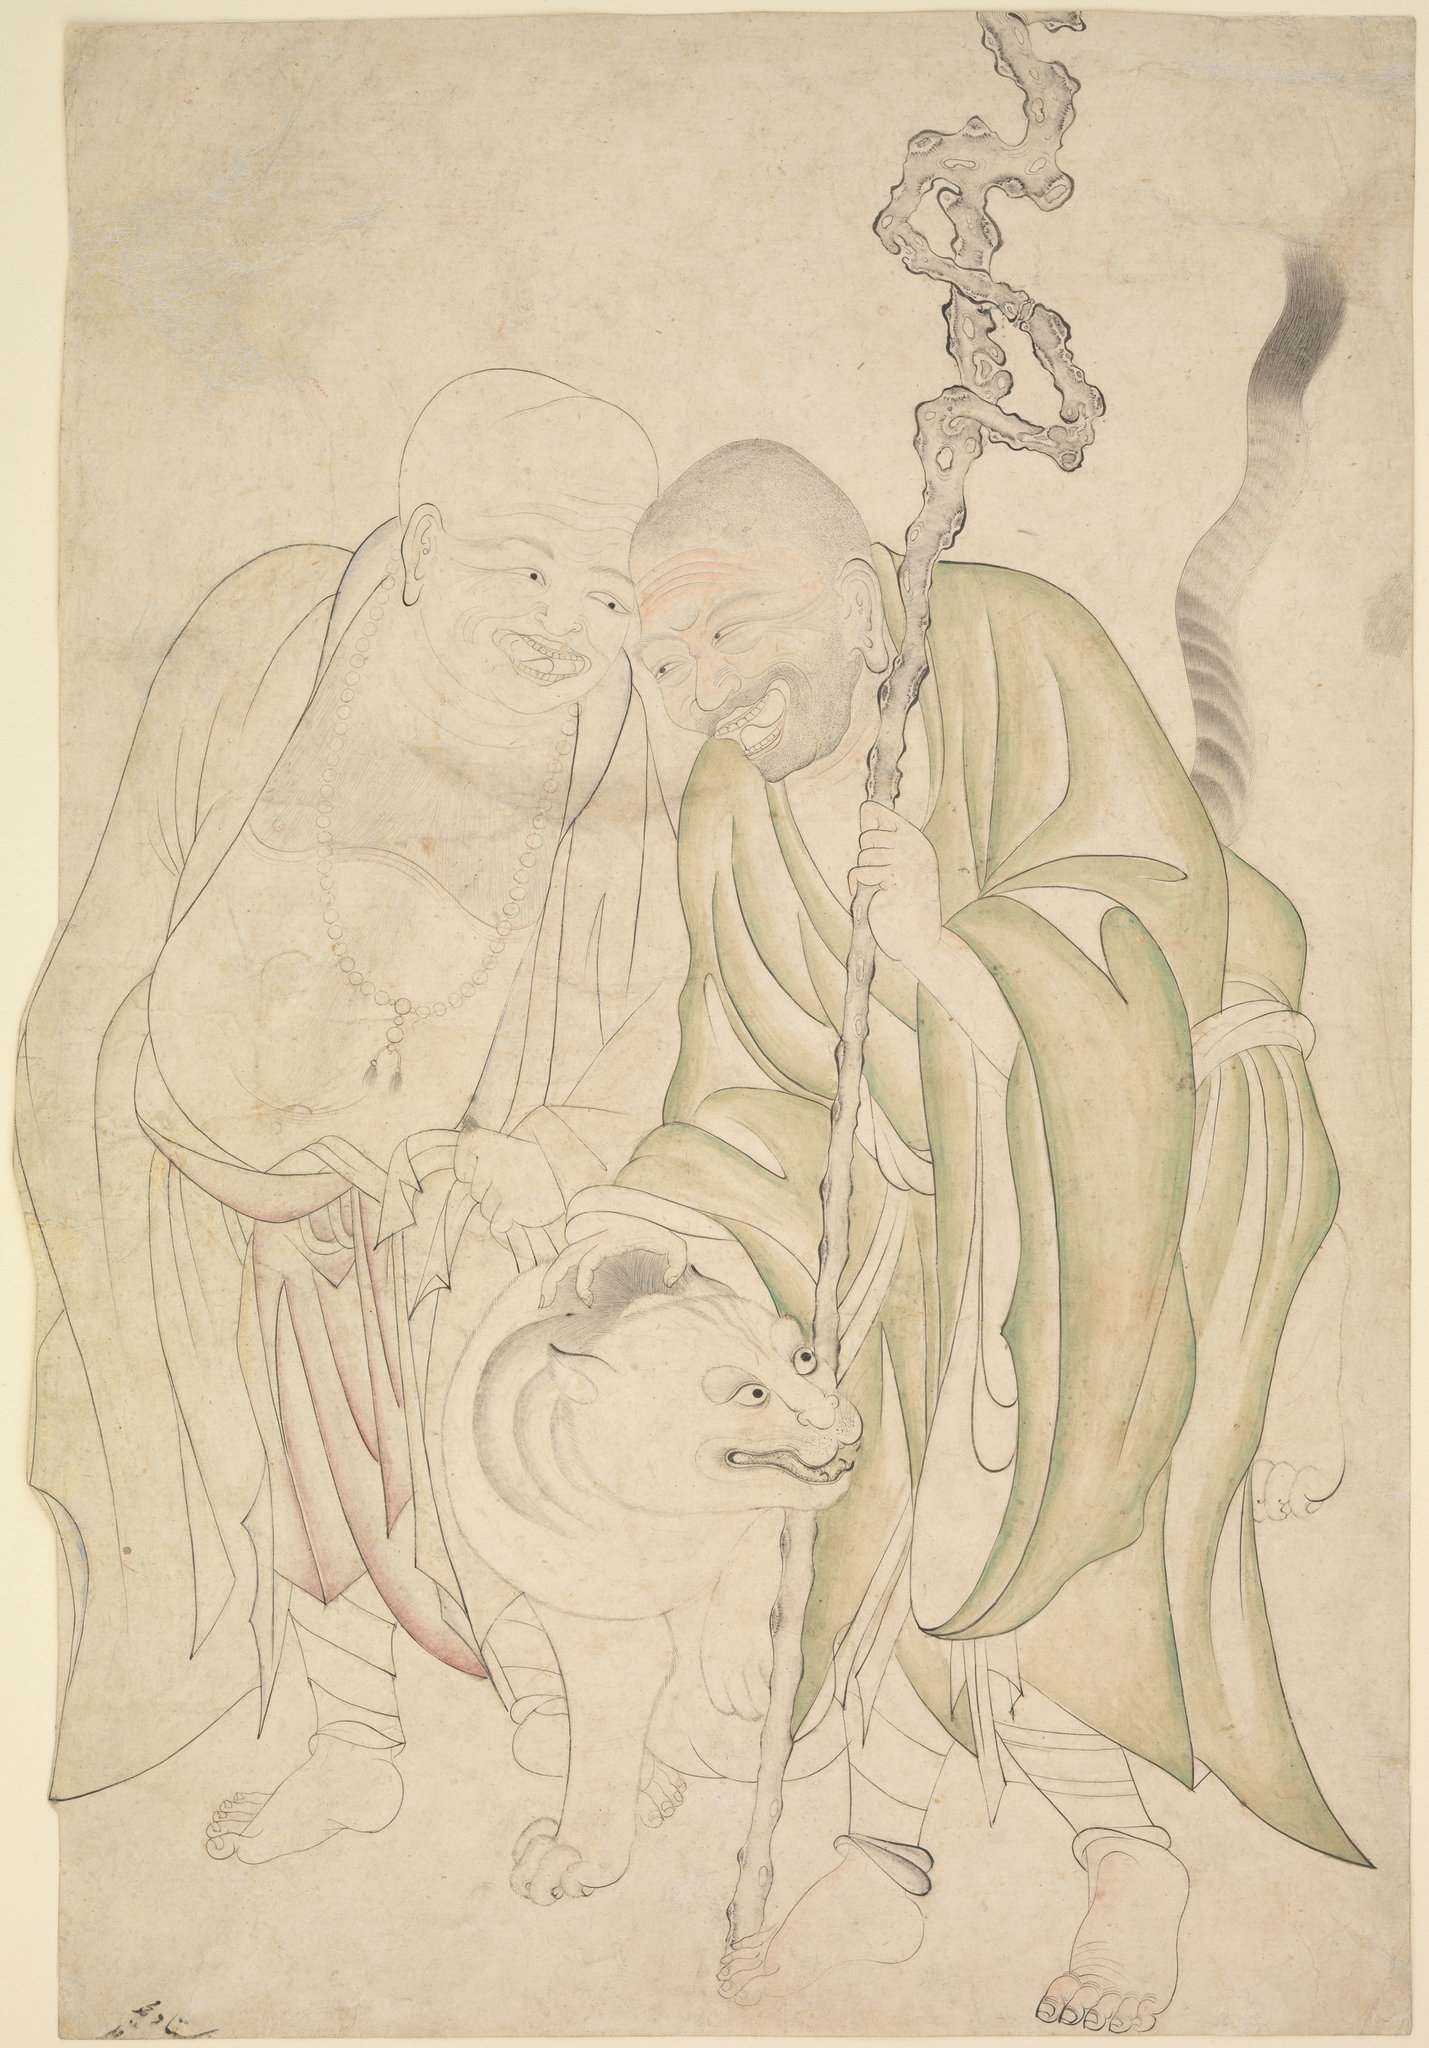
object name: illustrated single work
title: Two Lohans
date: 1480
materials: ink, paper, watercolor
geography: iran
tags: animals,men